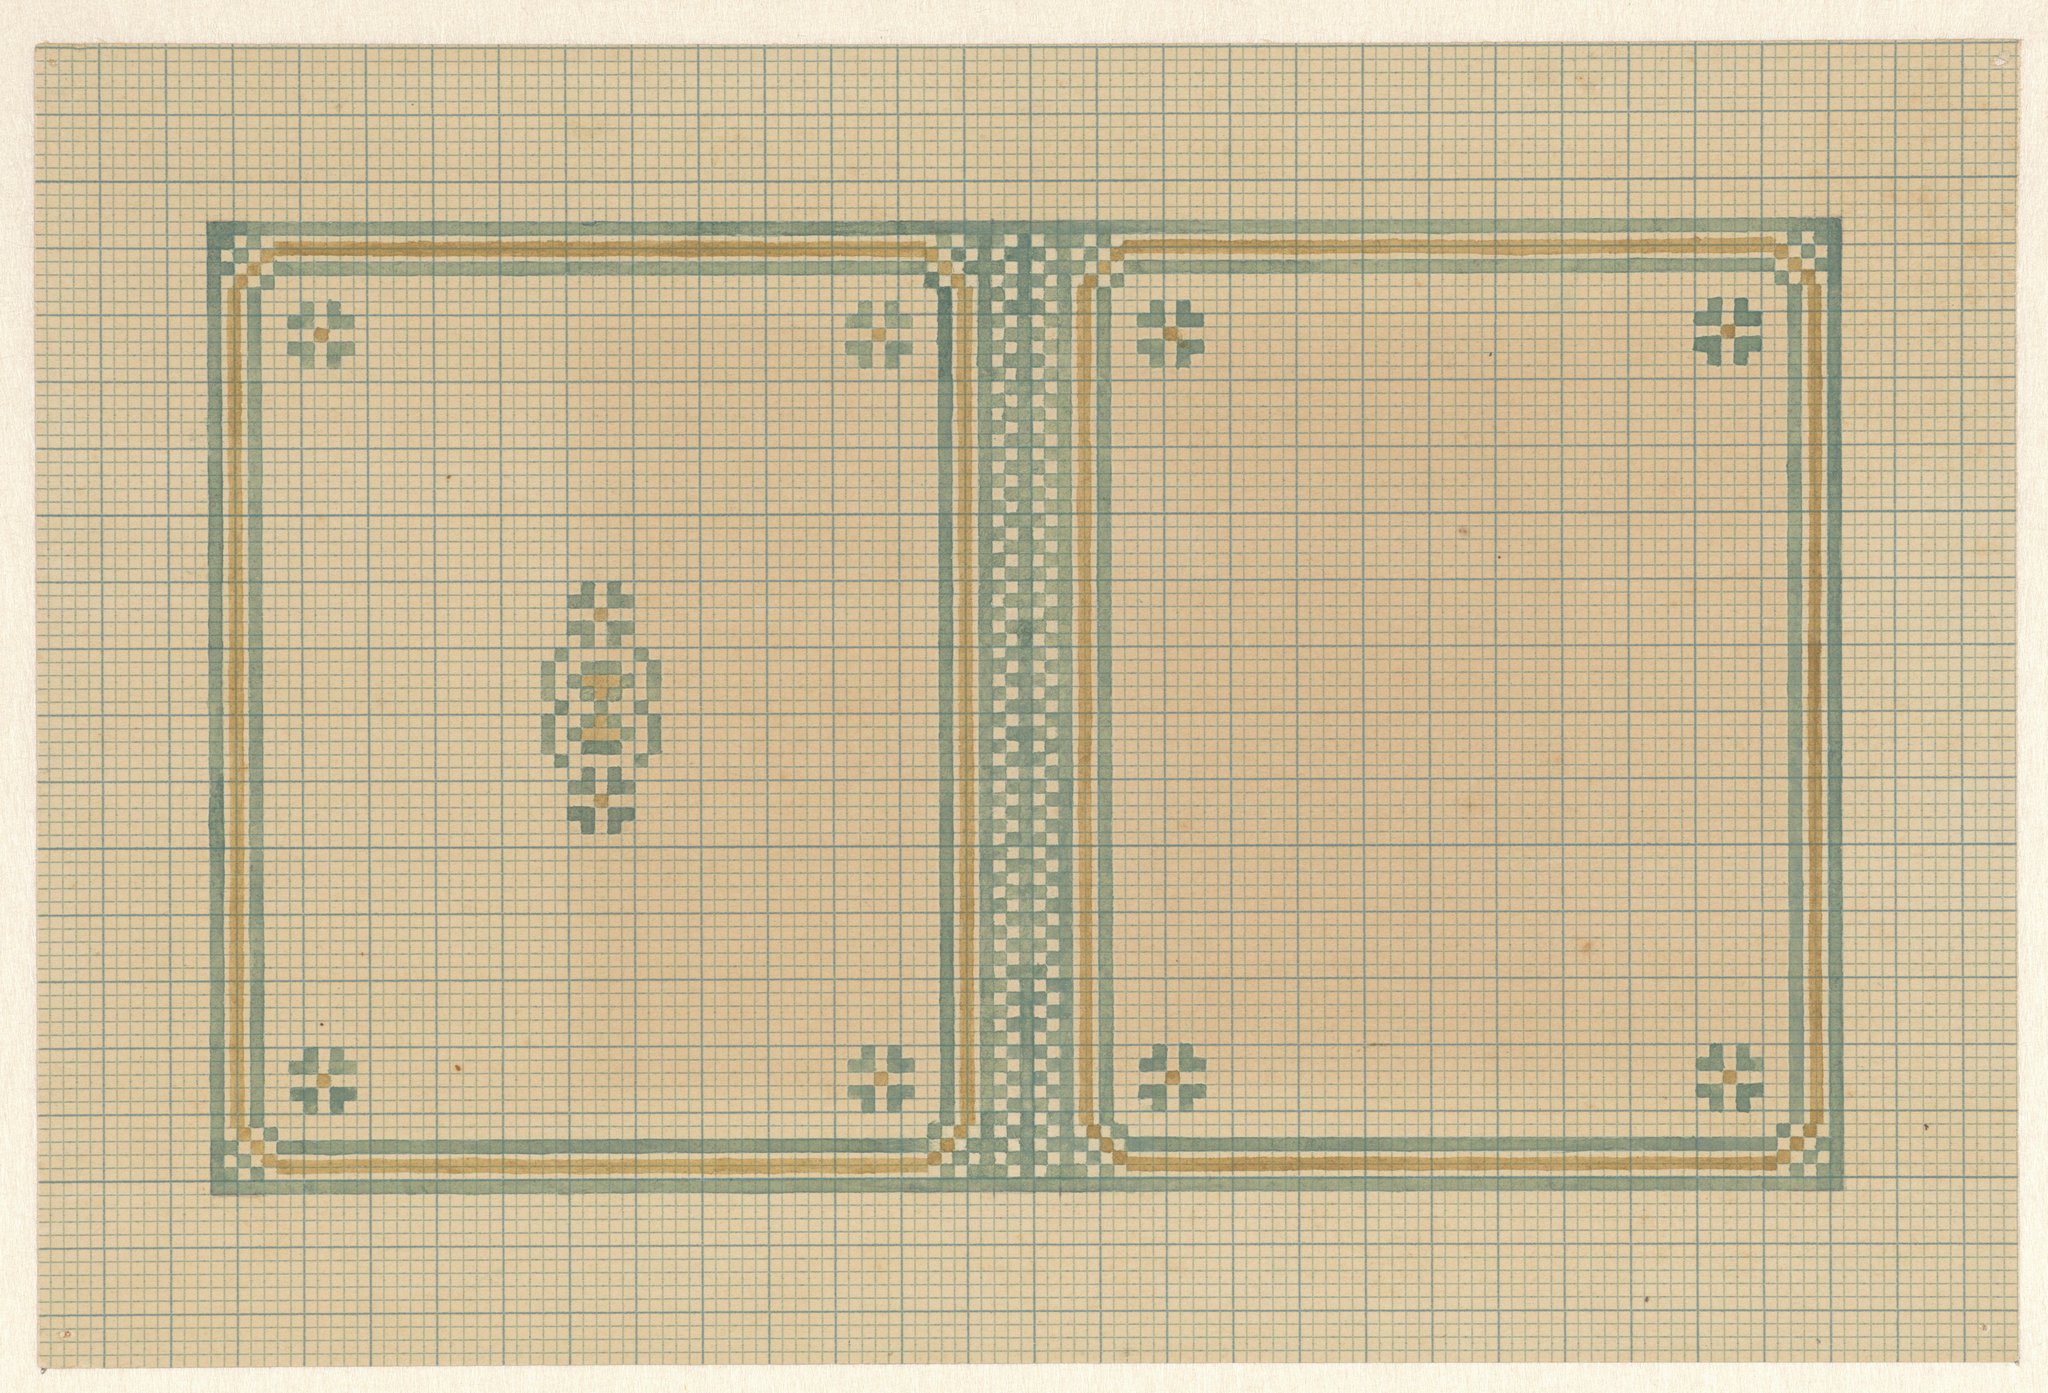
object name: drawing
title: Ontwerp voor het borduurwerk op een boekomslag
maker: johanna quirina van regteren altena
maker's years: 1876-1954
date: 1886-1954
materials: squared paper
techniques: brush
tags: book-cover, binding